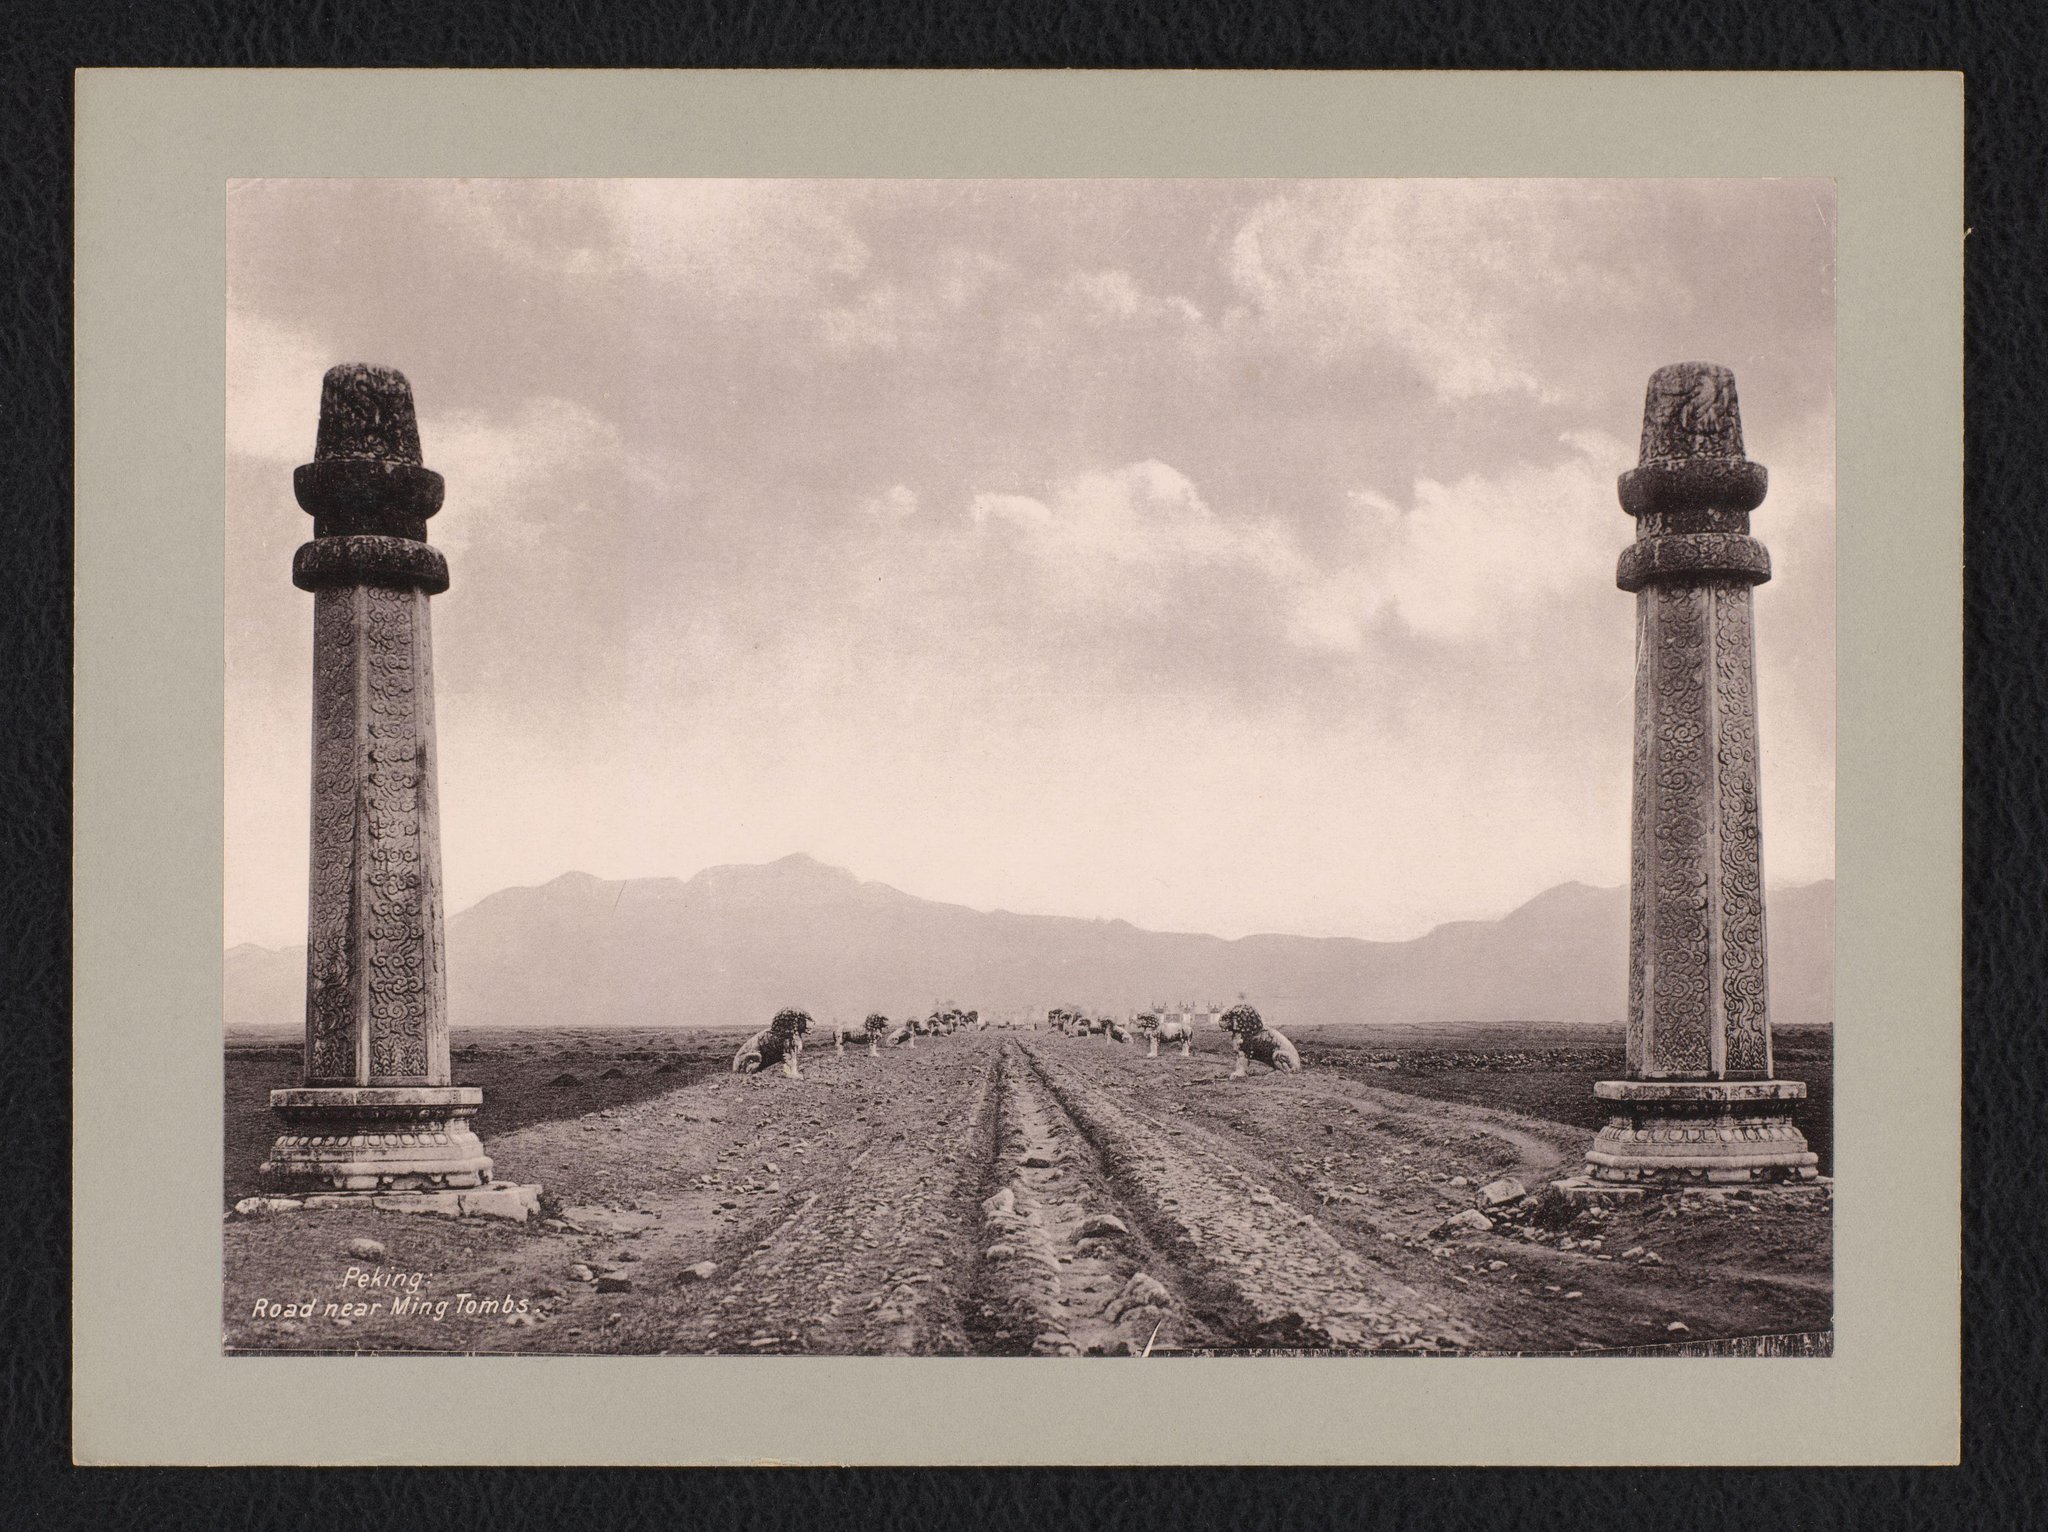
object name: photograph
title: Weg nabij Ming graftomben, Peking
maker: Anonymous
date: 1895-1915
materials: cardboard, photographic support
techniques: photograph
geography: beijing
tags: peking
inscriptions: number: ‘16.’